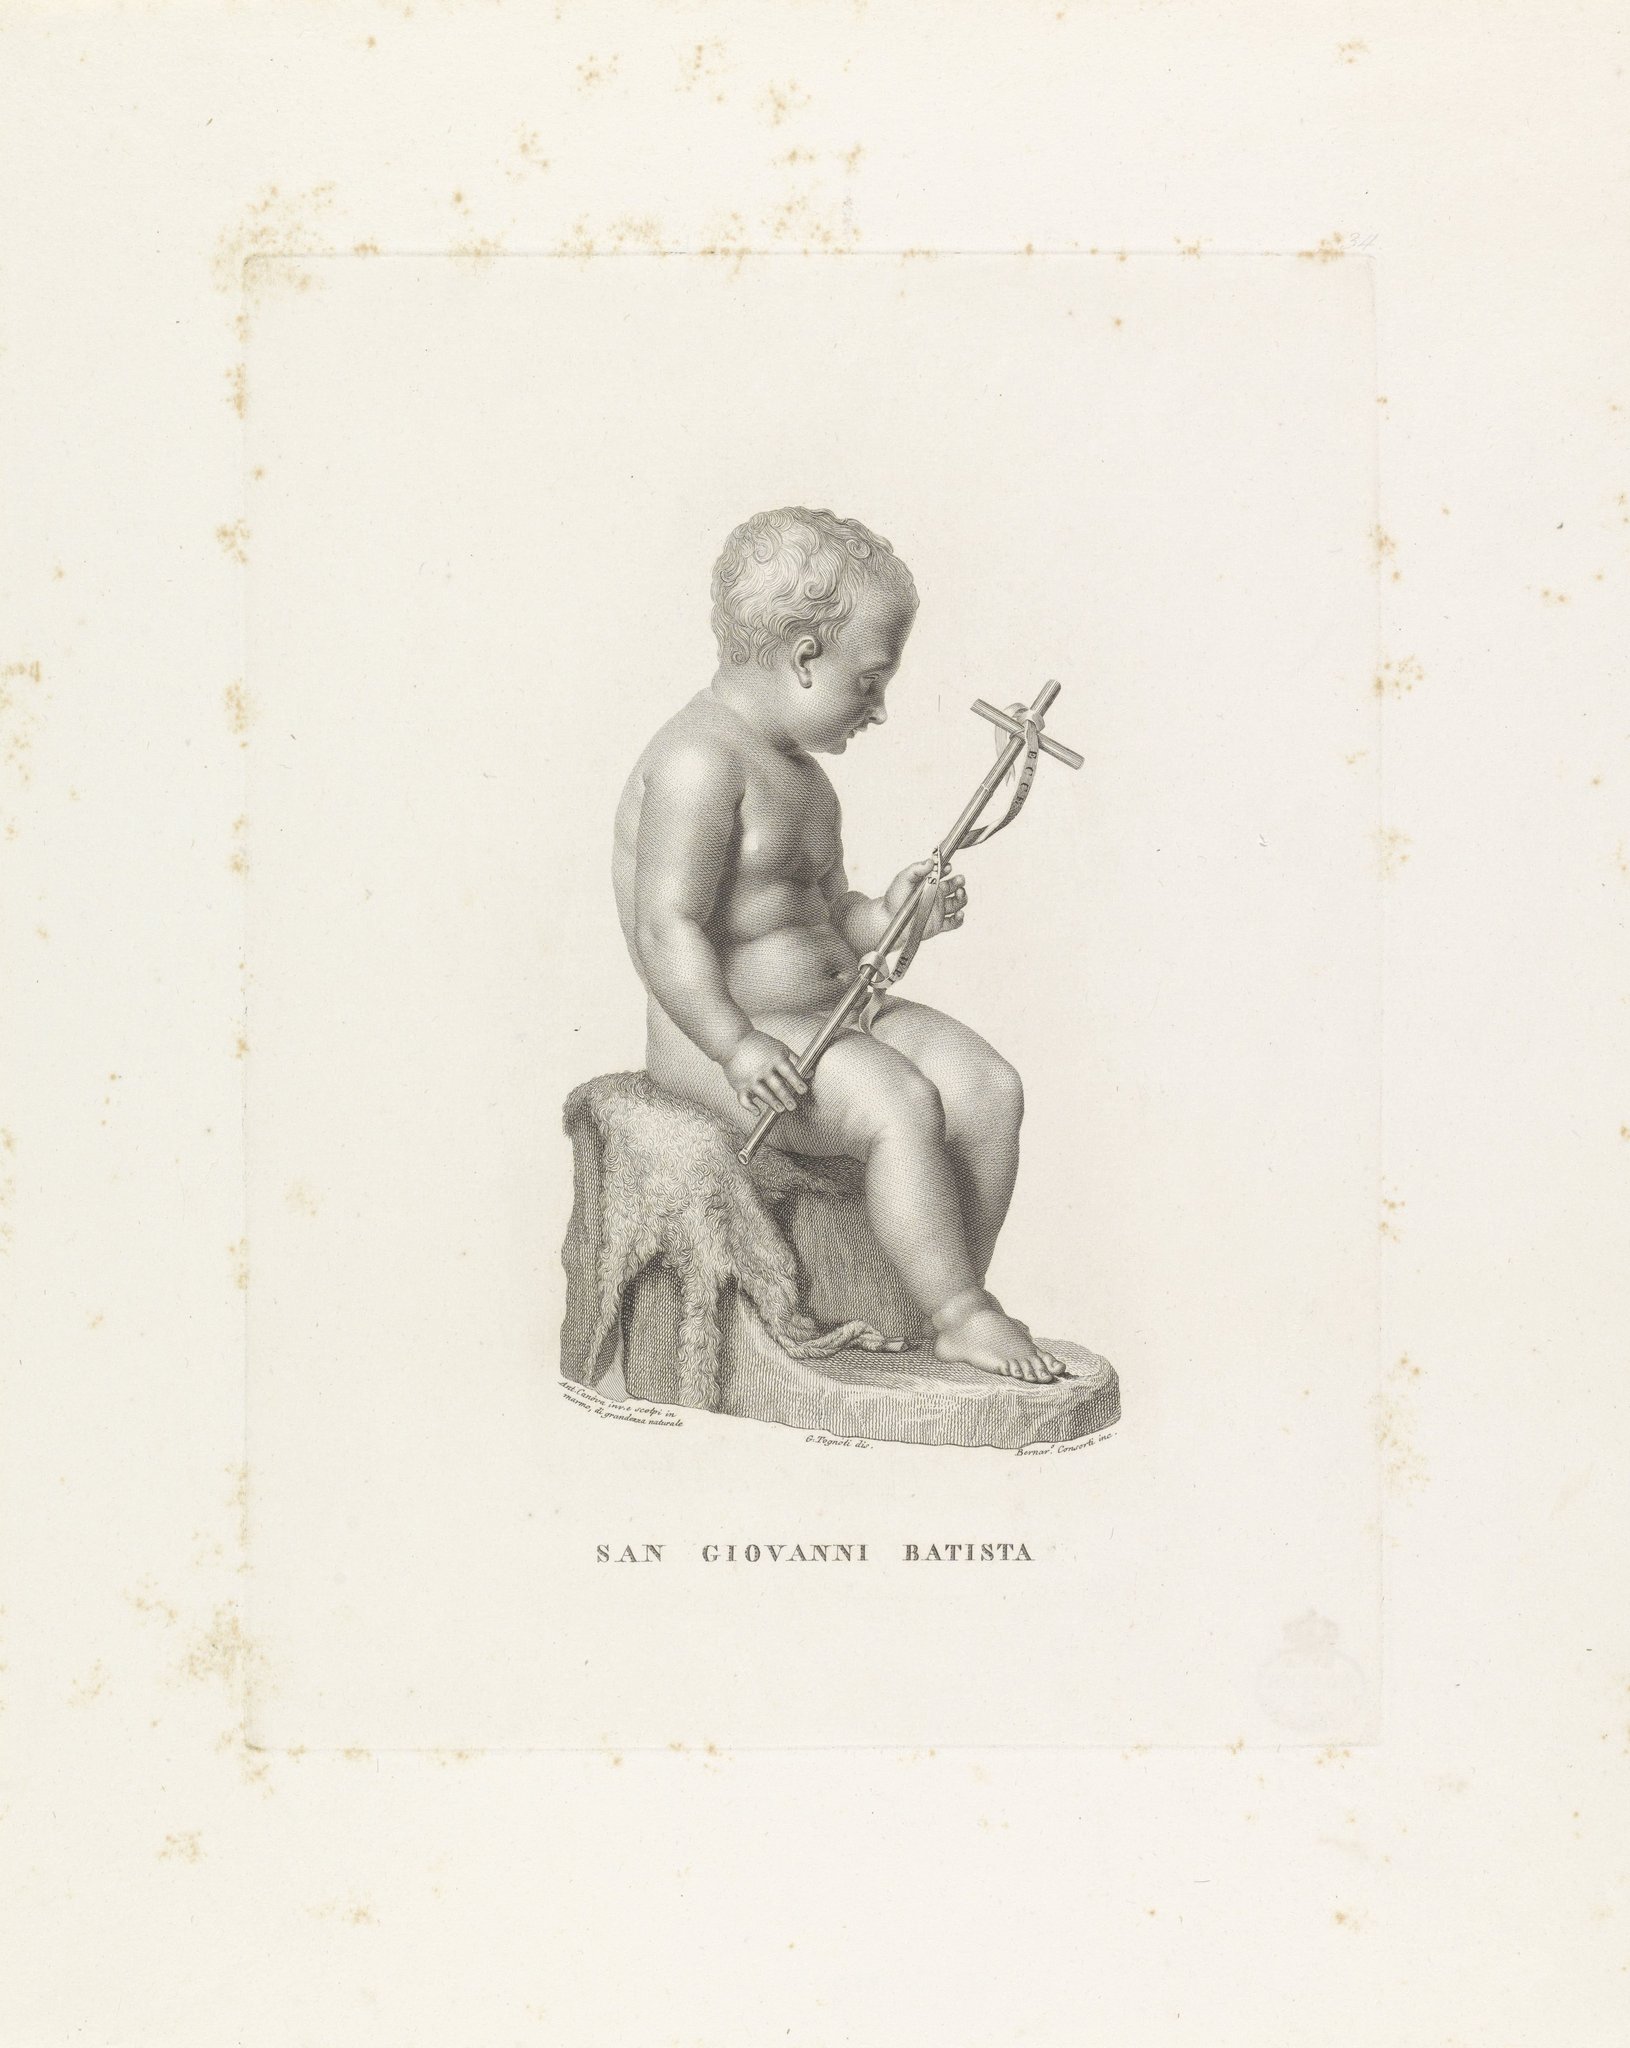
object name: print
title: De jonge Johannes de Doper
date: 1790-1859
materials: paper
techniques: engraving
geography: italy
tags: john the baptist; possible attributes: book, reed cross, baptismal cup, honeycomb, lamb, staff, piece of sculpture, reproduction of a piece of sculpture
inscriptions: collector's mark: Lugt 12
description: Deze prent maakt deel uit van een reeks van onbekende omvang met voorstellingen van sculpturen van Antonio Canova door verschillende prentmakers naar tekeningen van Giovanni Tognolli.